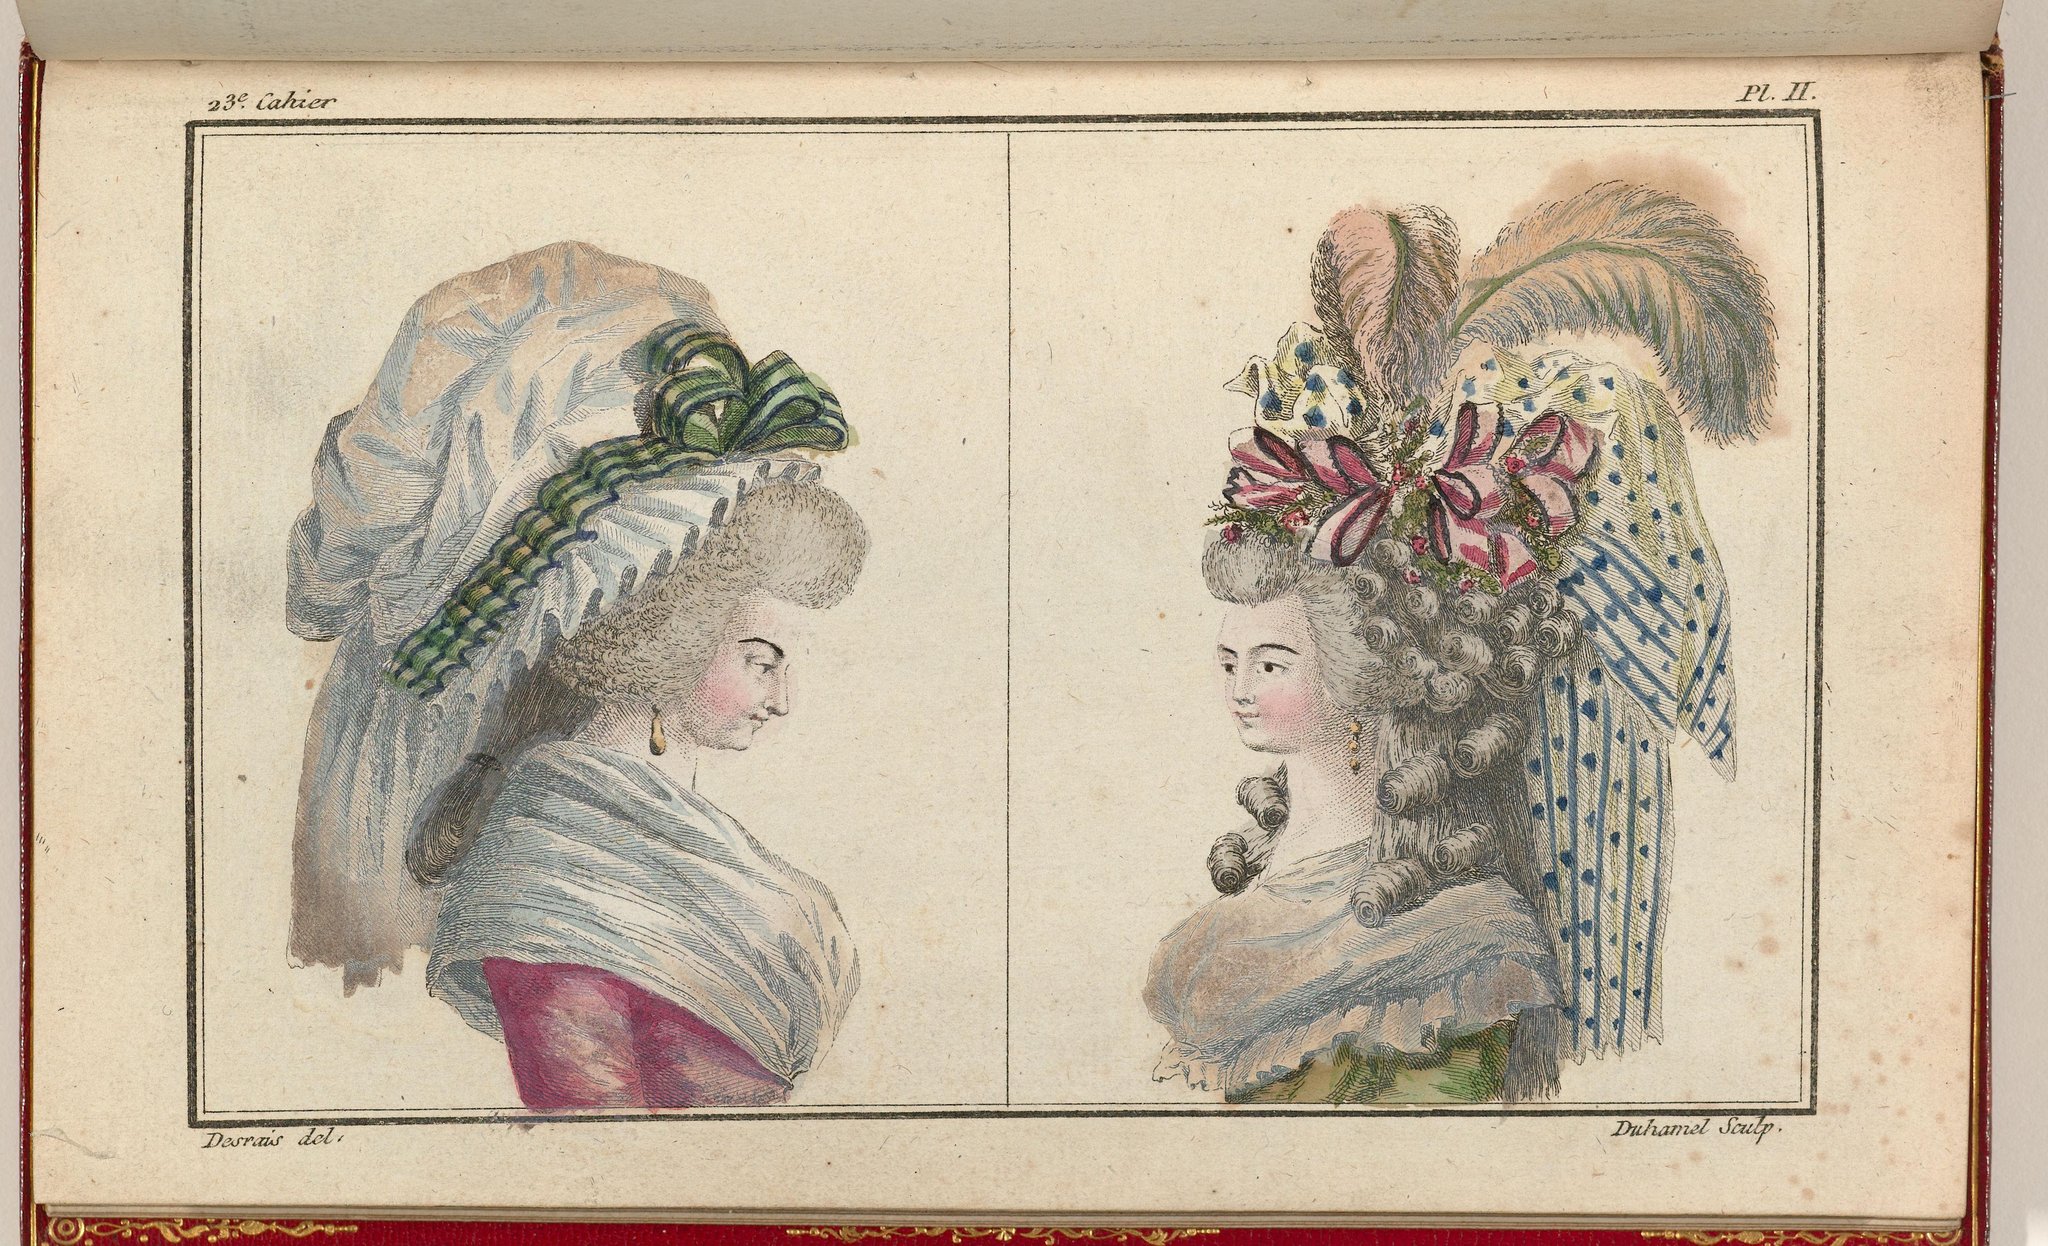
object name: fashion print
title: Cabinet des Modes ou les Modes Nouvelles, 15 Octobre 1786, pl. II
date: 1786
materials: paper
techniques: engraving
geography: paris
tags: ear-rings (+ women's clothes), head-gear (pouf) (+ women's clothes), head-gear (baigneuse) (+ women's clothes), styles of hairdress - aa - ~ women, head-gear: cap (+ women's clothes), fashion plates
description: Twee vrouwenbustes met hoeden: links een 'Baigneuse', rechts een 'Pouf à la Virginie'.